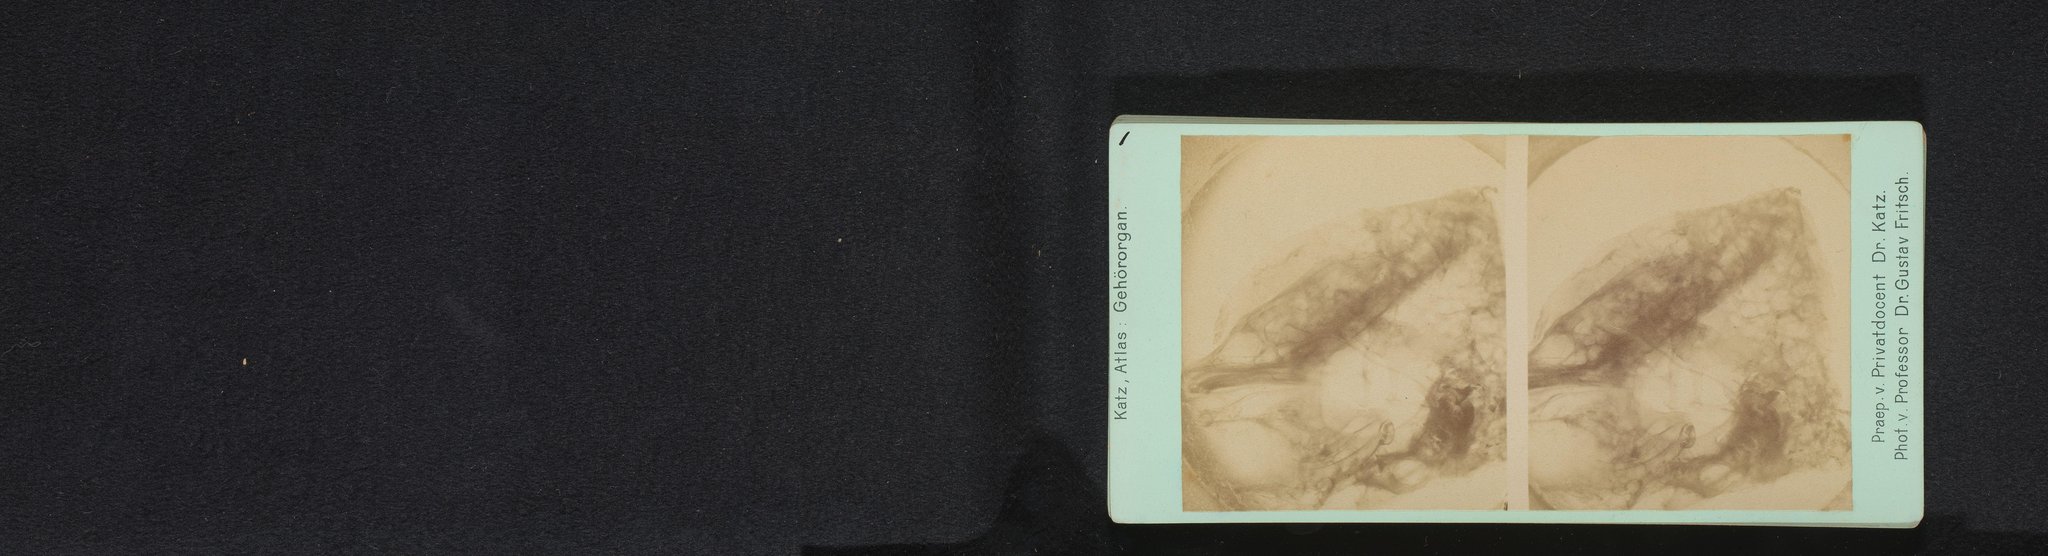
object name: page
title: Katz, Atlas: Gehörorgan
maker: gustav fritsch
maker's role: professor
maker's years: 1838-1927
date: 1885-1895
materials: photographic support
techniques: albumen print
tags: ears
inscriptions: number: ‘1’